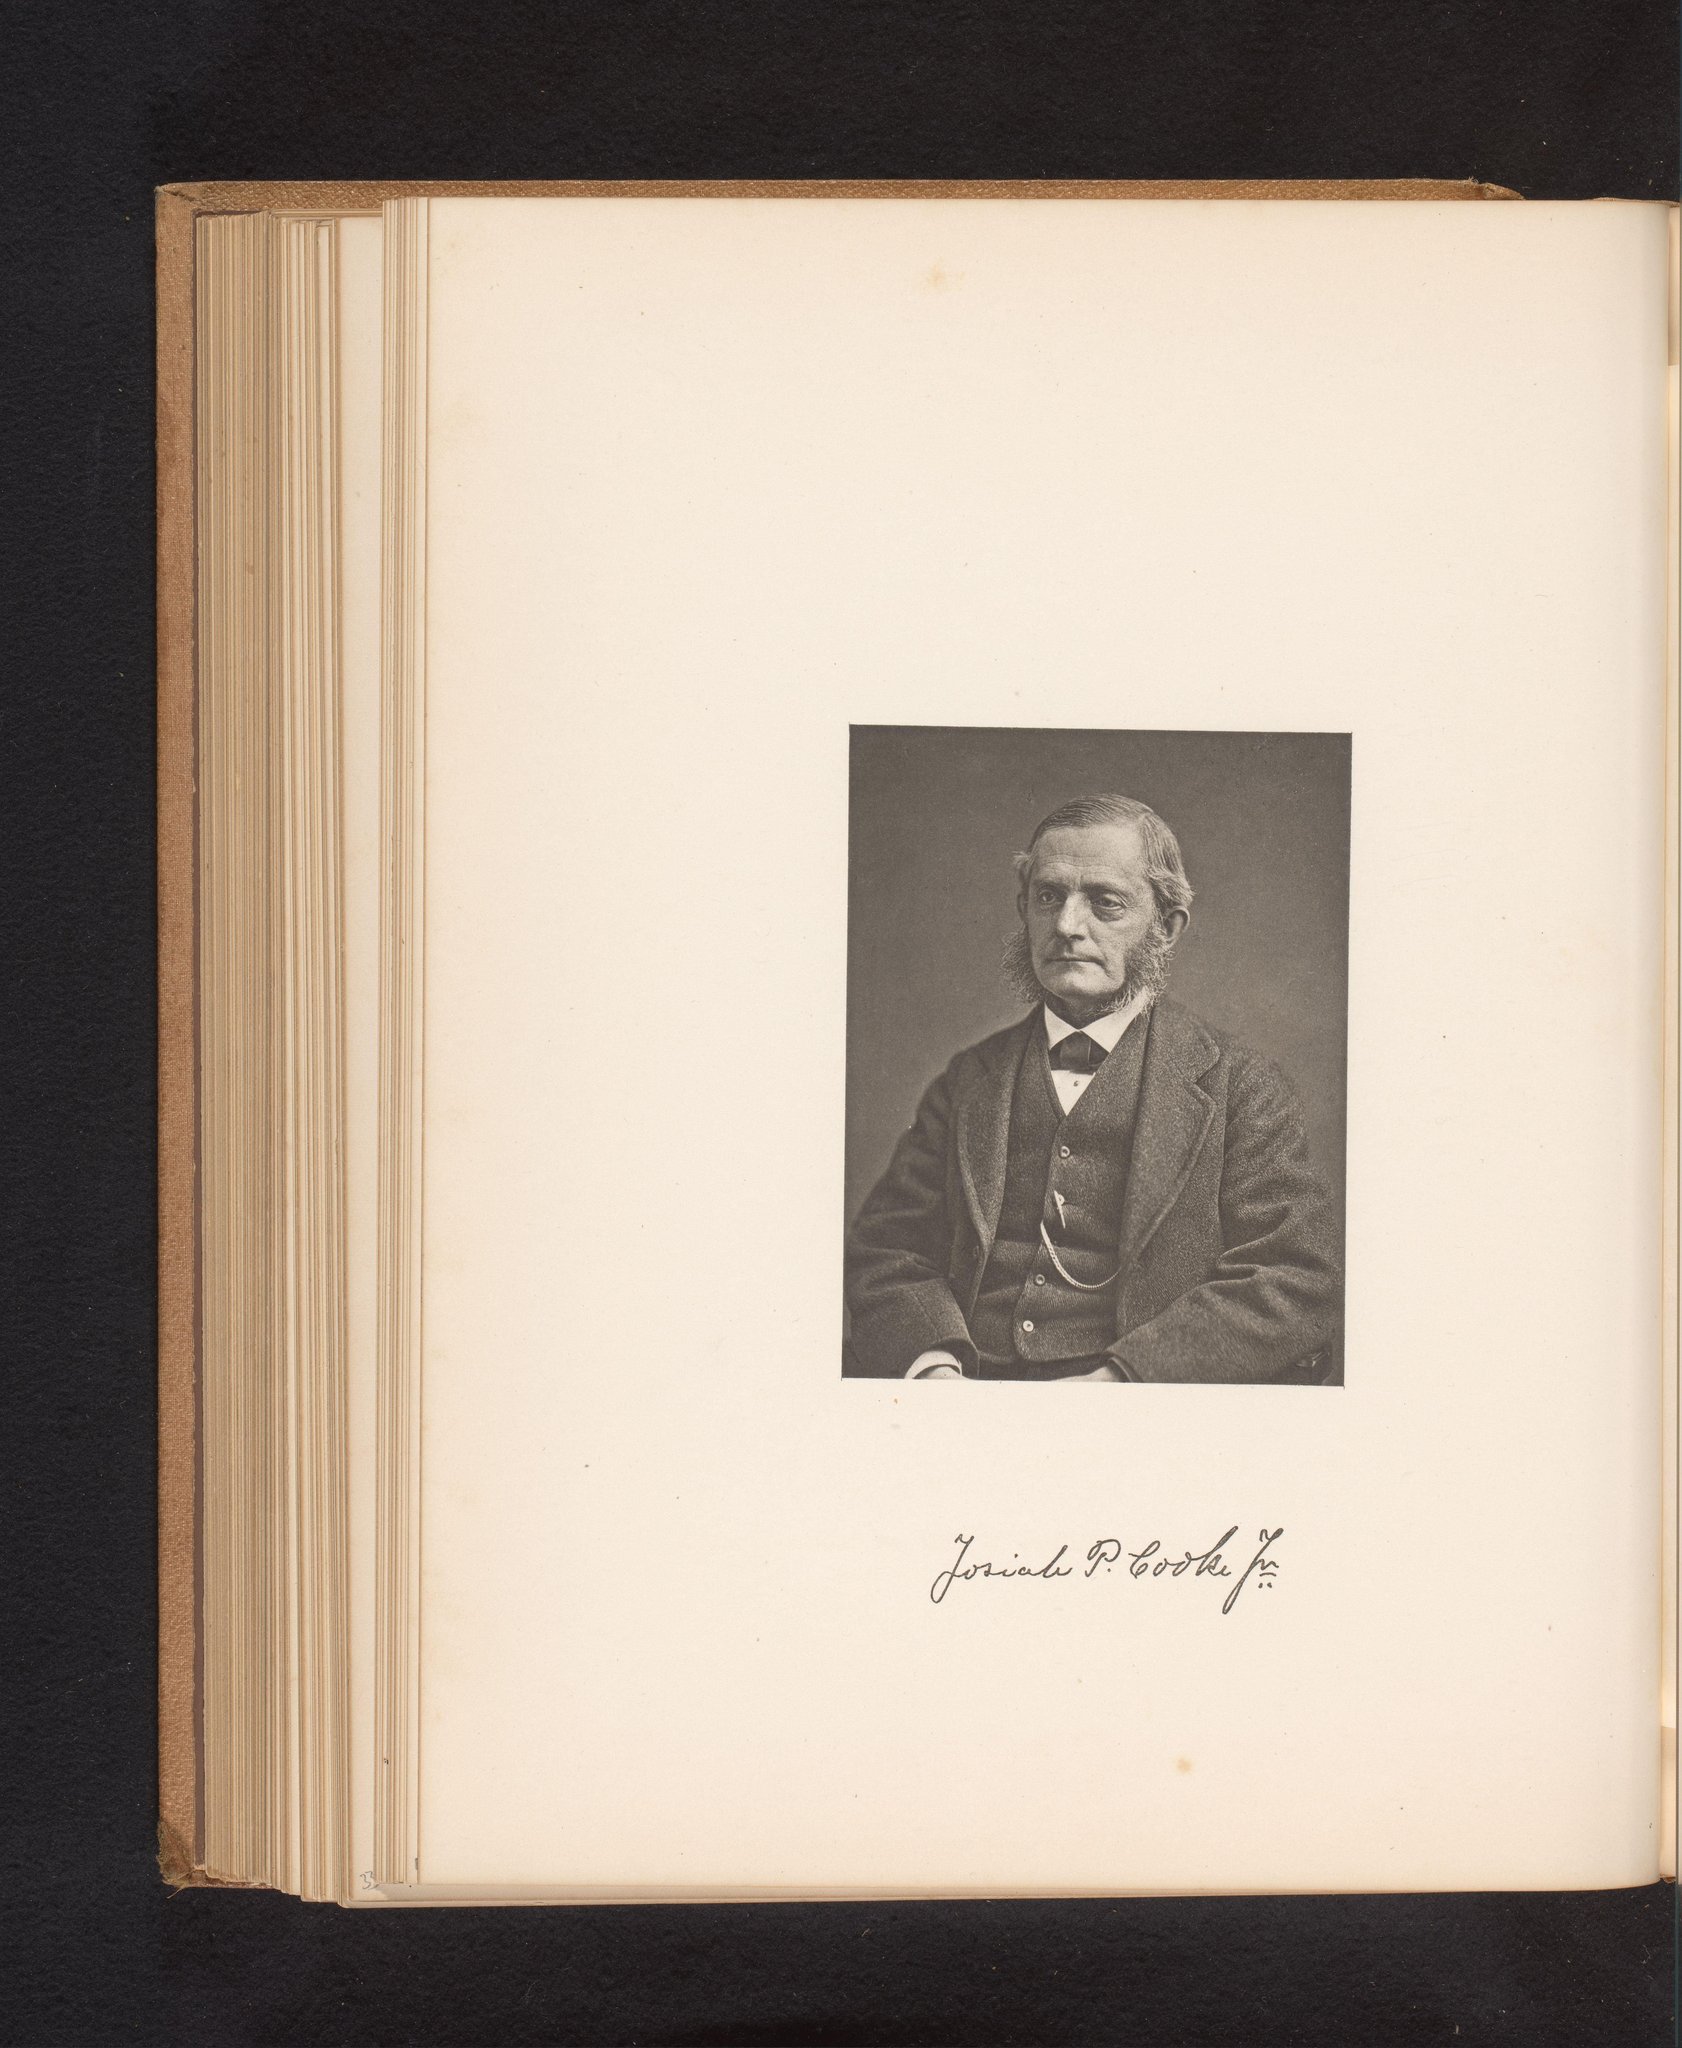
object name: photomechanical print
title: Josiah P. Cooke jr.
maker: Anonymous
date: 1870-1875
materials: paper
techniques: photograph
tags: historical persons, professor